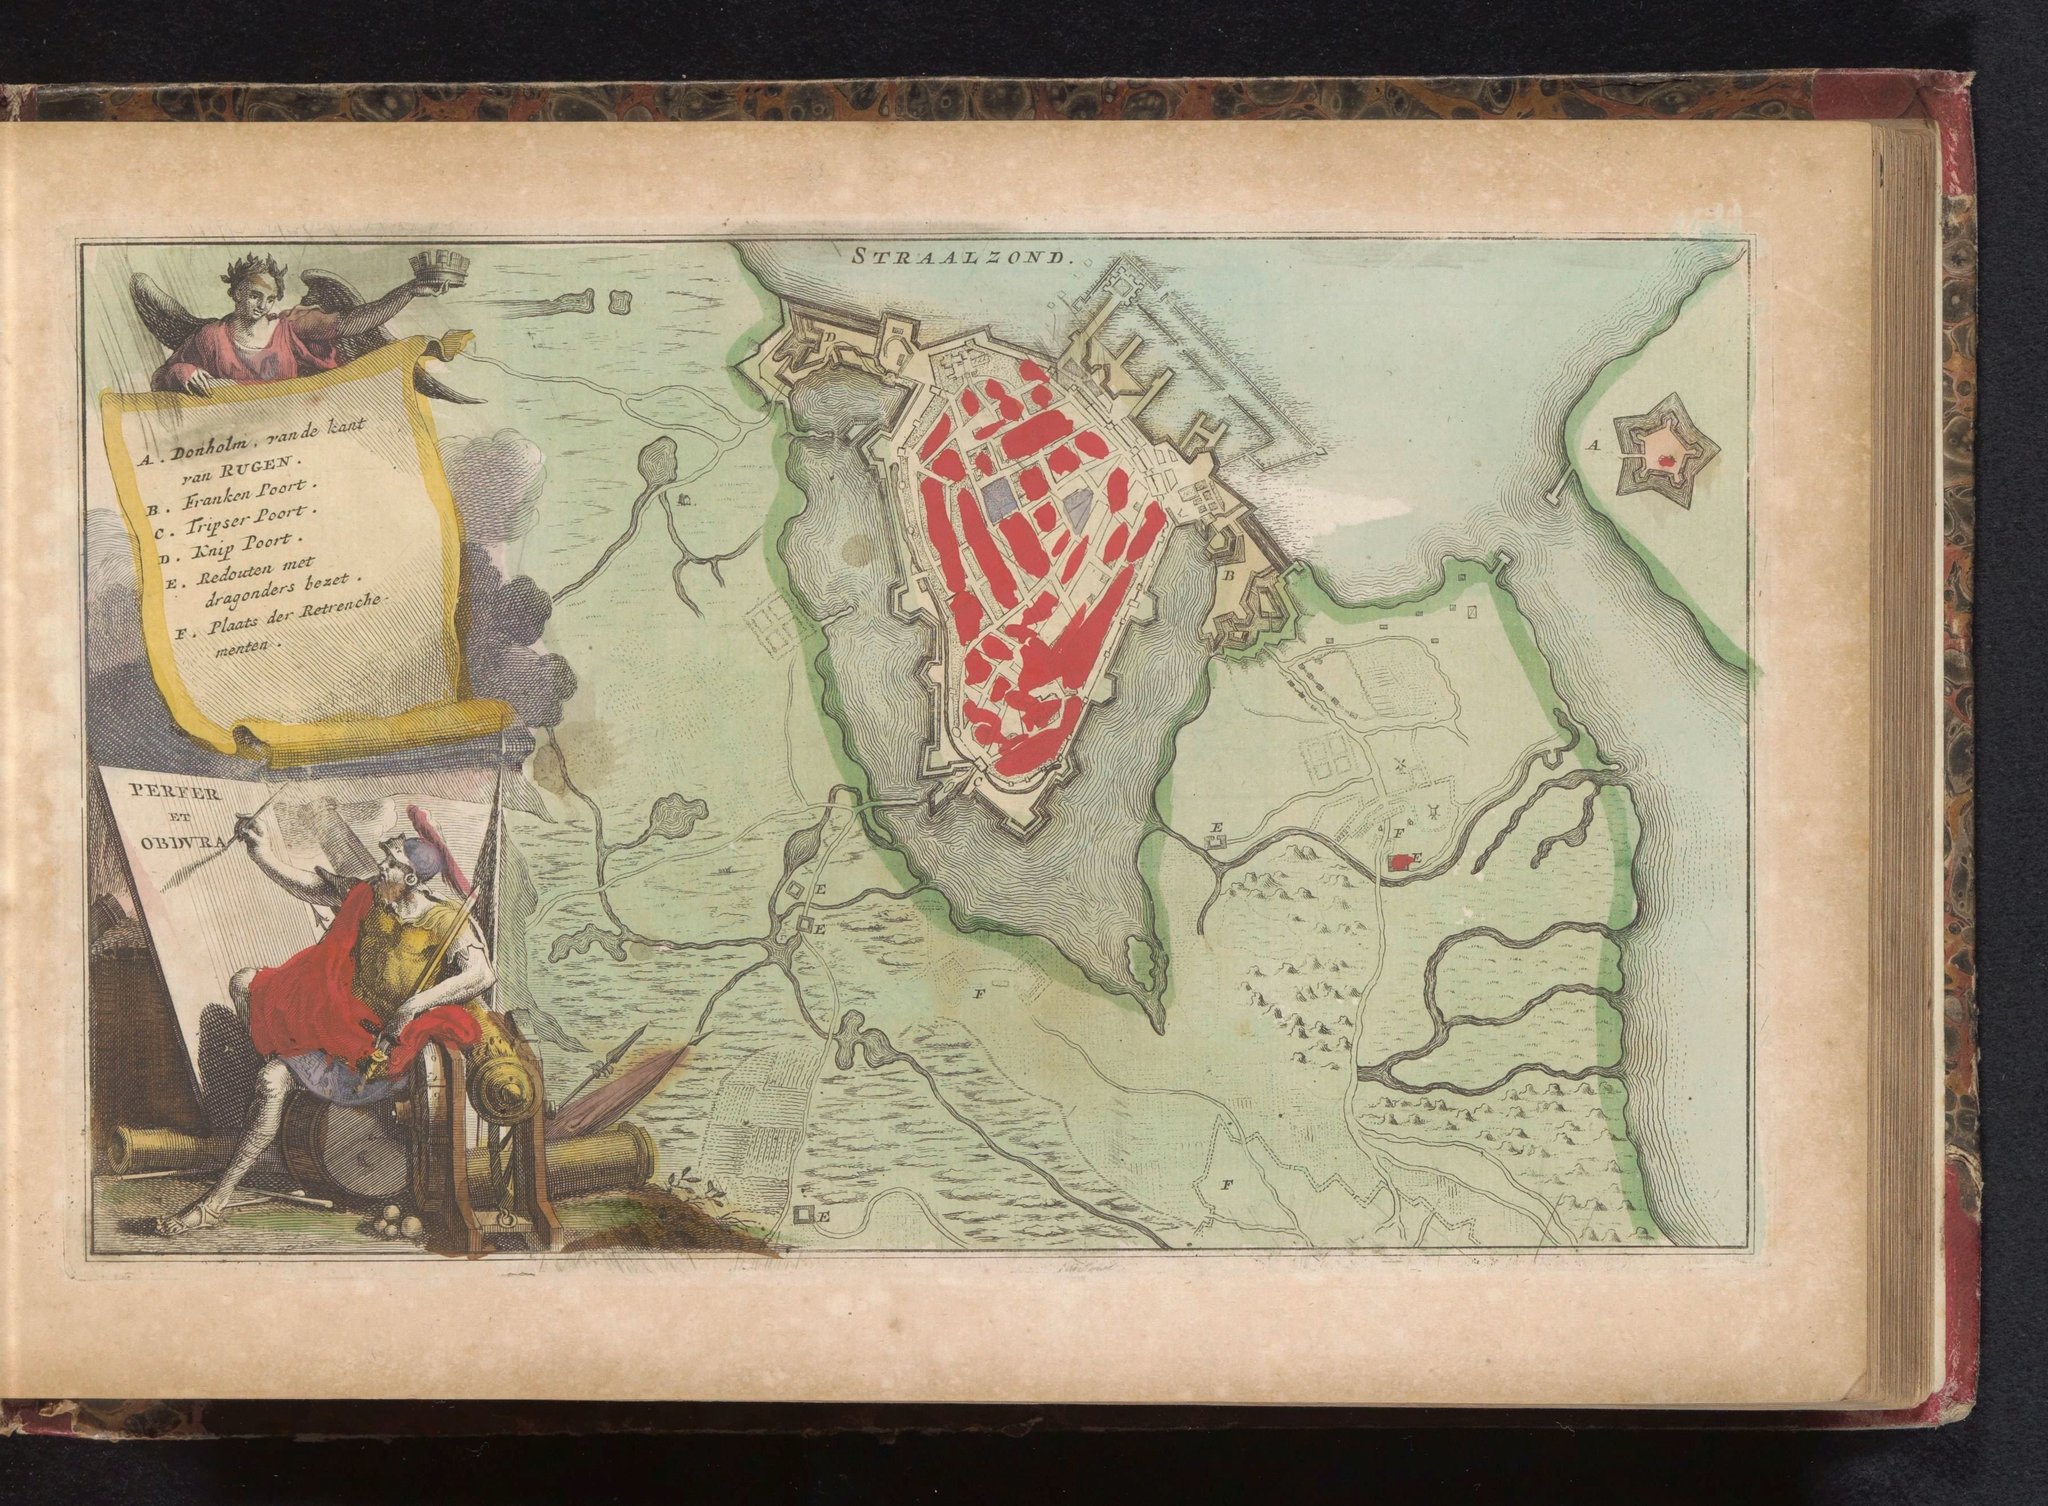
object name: map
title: Plattegrond van Stralsund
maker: Anonymous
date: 1735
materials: paper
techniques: engraving, etching, hand coloring, lacquer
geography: amsterdam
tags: fortress, maps of cities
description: Plattegrond van Stralsund. Linksonder een soldaat die op een tablet schrijft. Onderdeel van een atlas met 223 kaarten van landen en steden en oorlogstaferelen in Europa in de periode ca. 1690-1735.